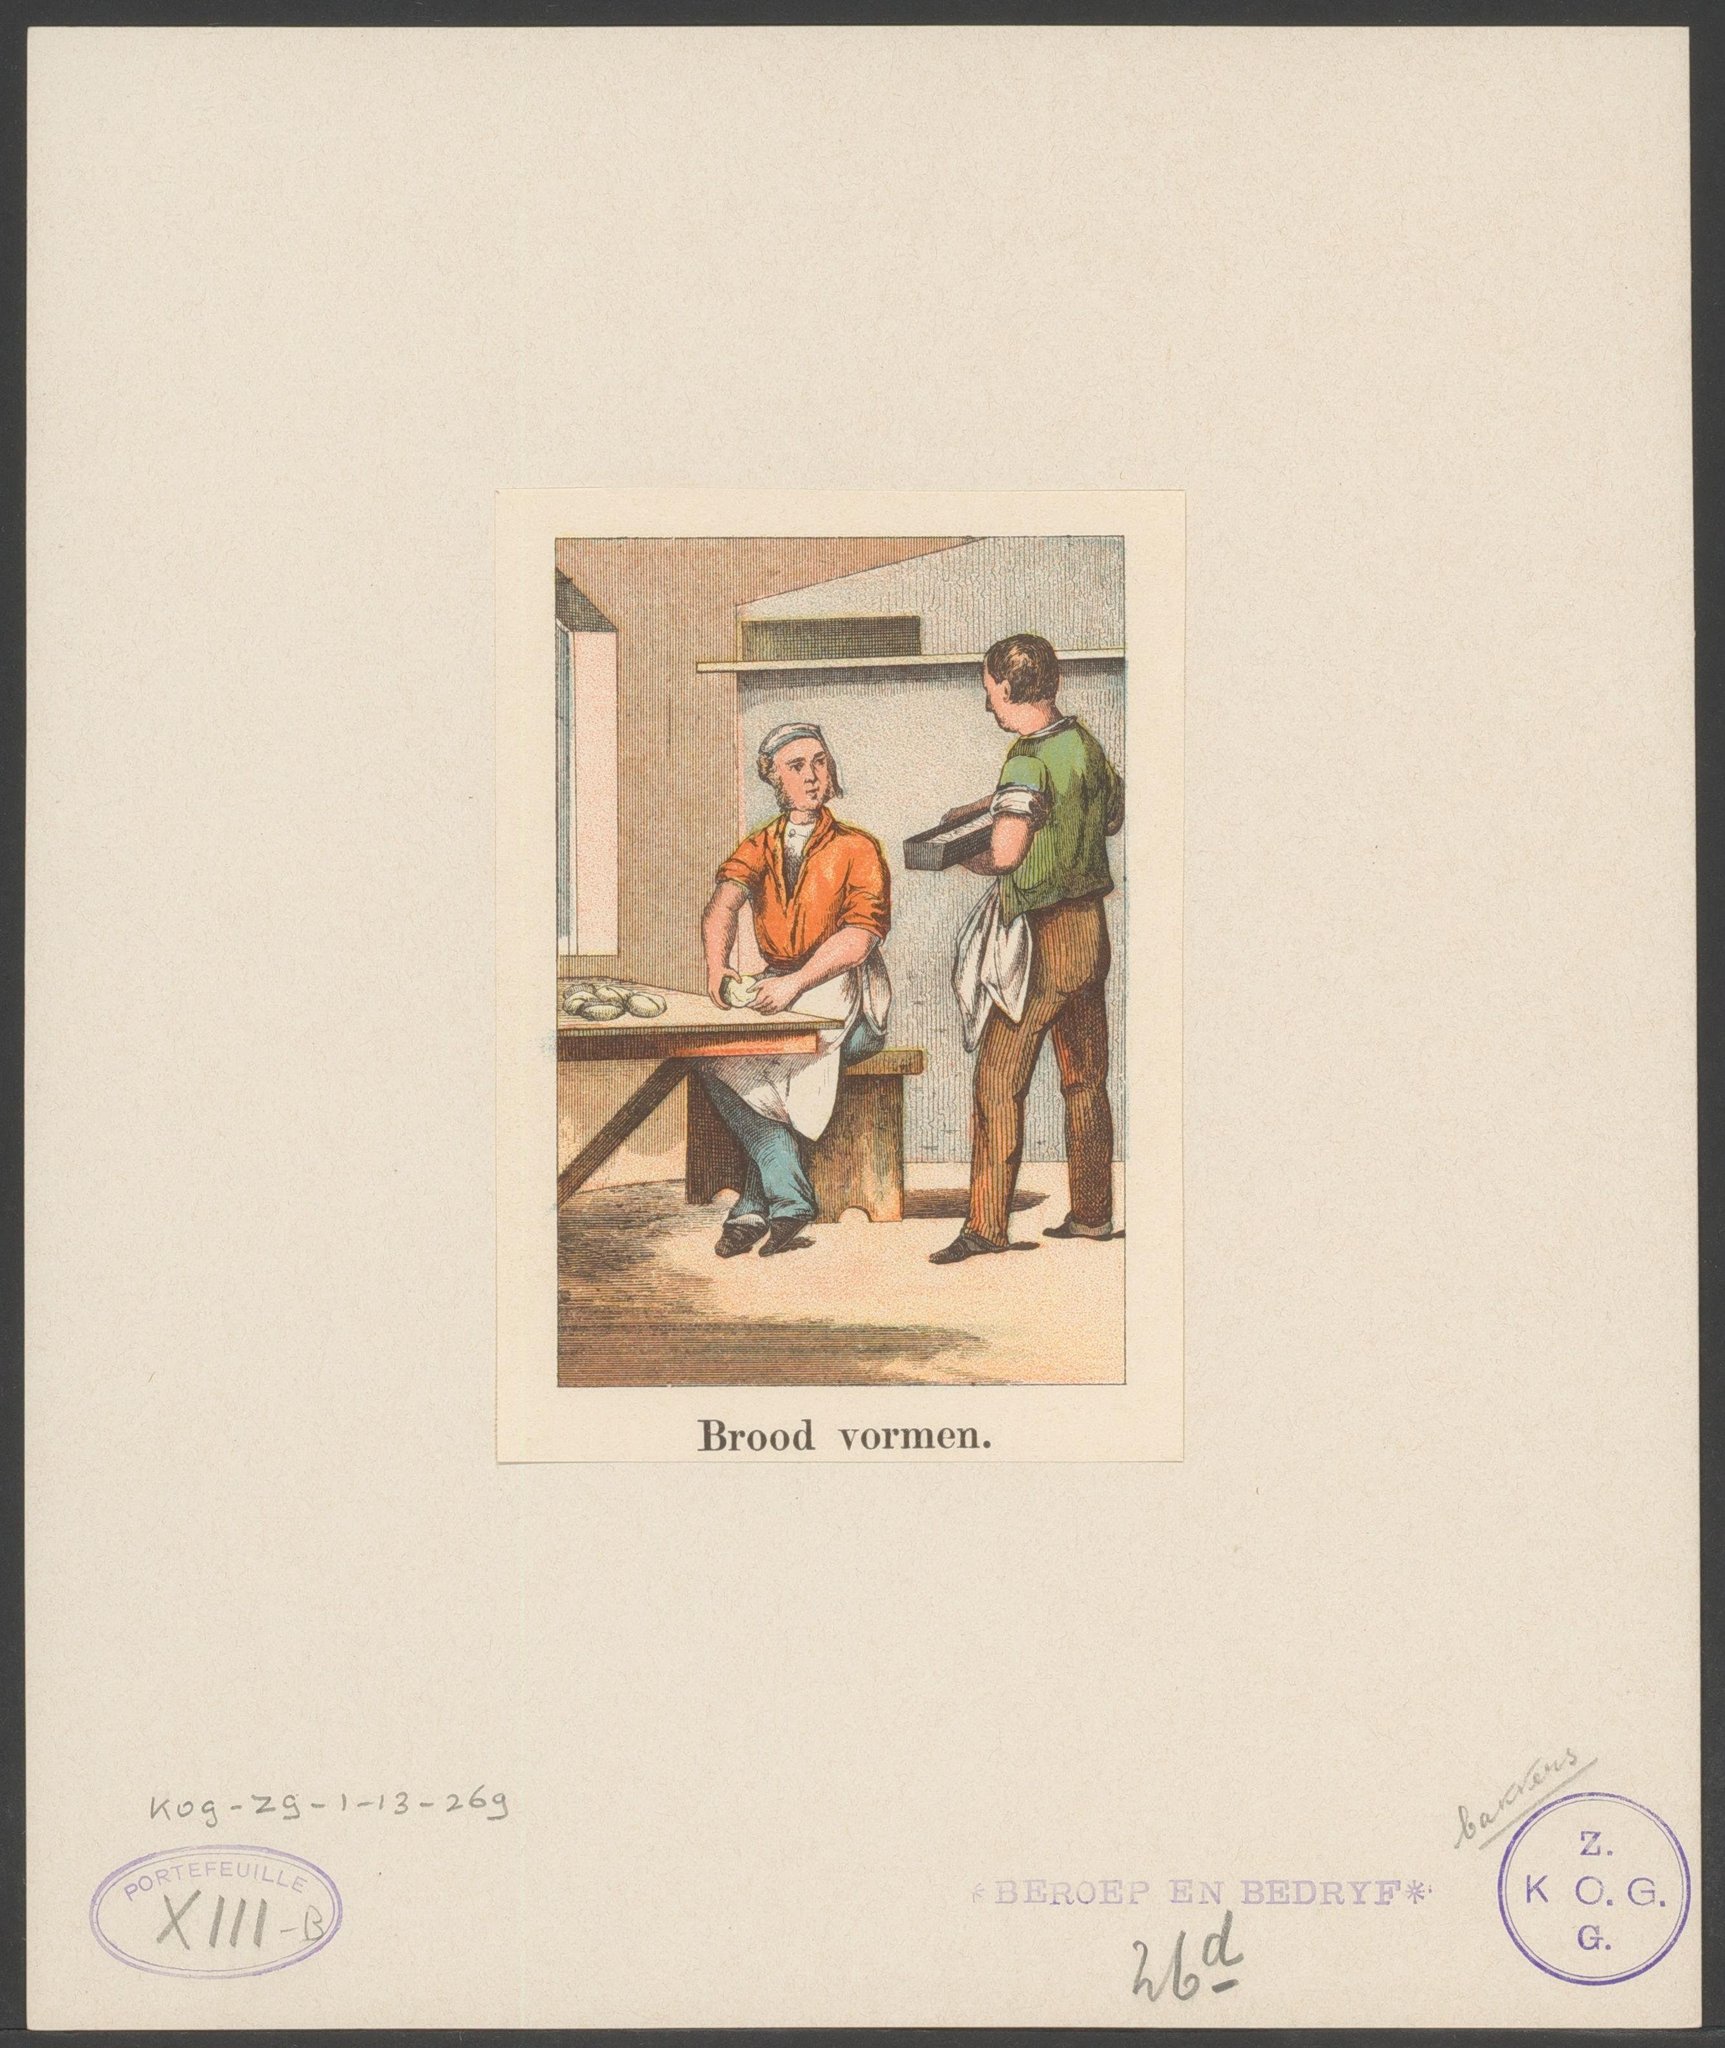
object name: popular print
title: Brood vormen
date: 1865-1872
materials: paper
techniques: lithograph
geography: amsterdam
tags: baker (+ labourers ~ crafts, industries, agriculture), baker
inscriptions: collector's mark: Lugt 1641, stamp, stamp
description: Onderwerpsrubrieken binnen de Atlas Zeden en Gewoonten: Handel, Nijverheid en Verkeer, Beroep en bedrijf, Mannelijk, Eet- en drinkwaren.